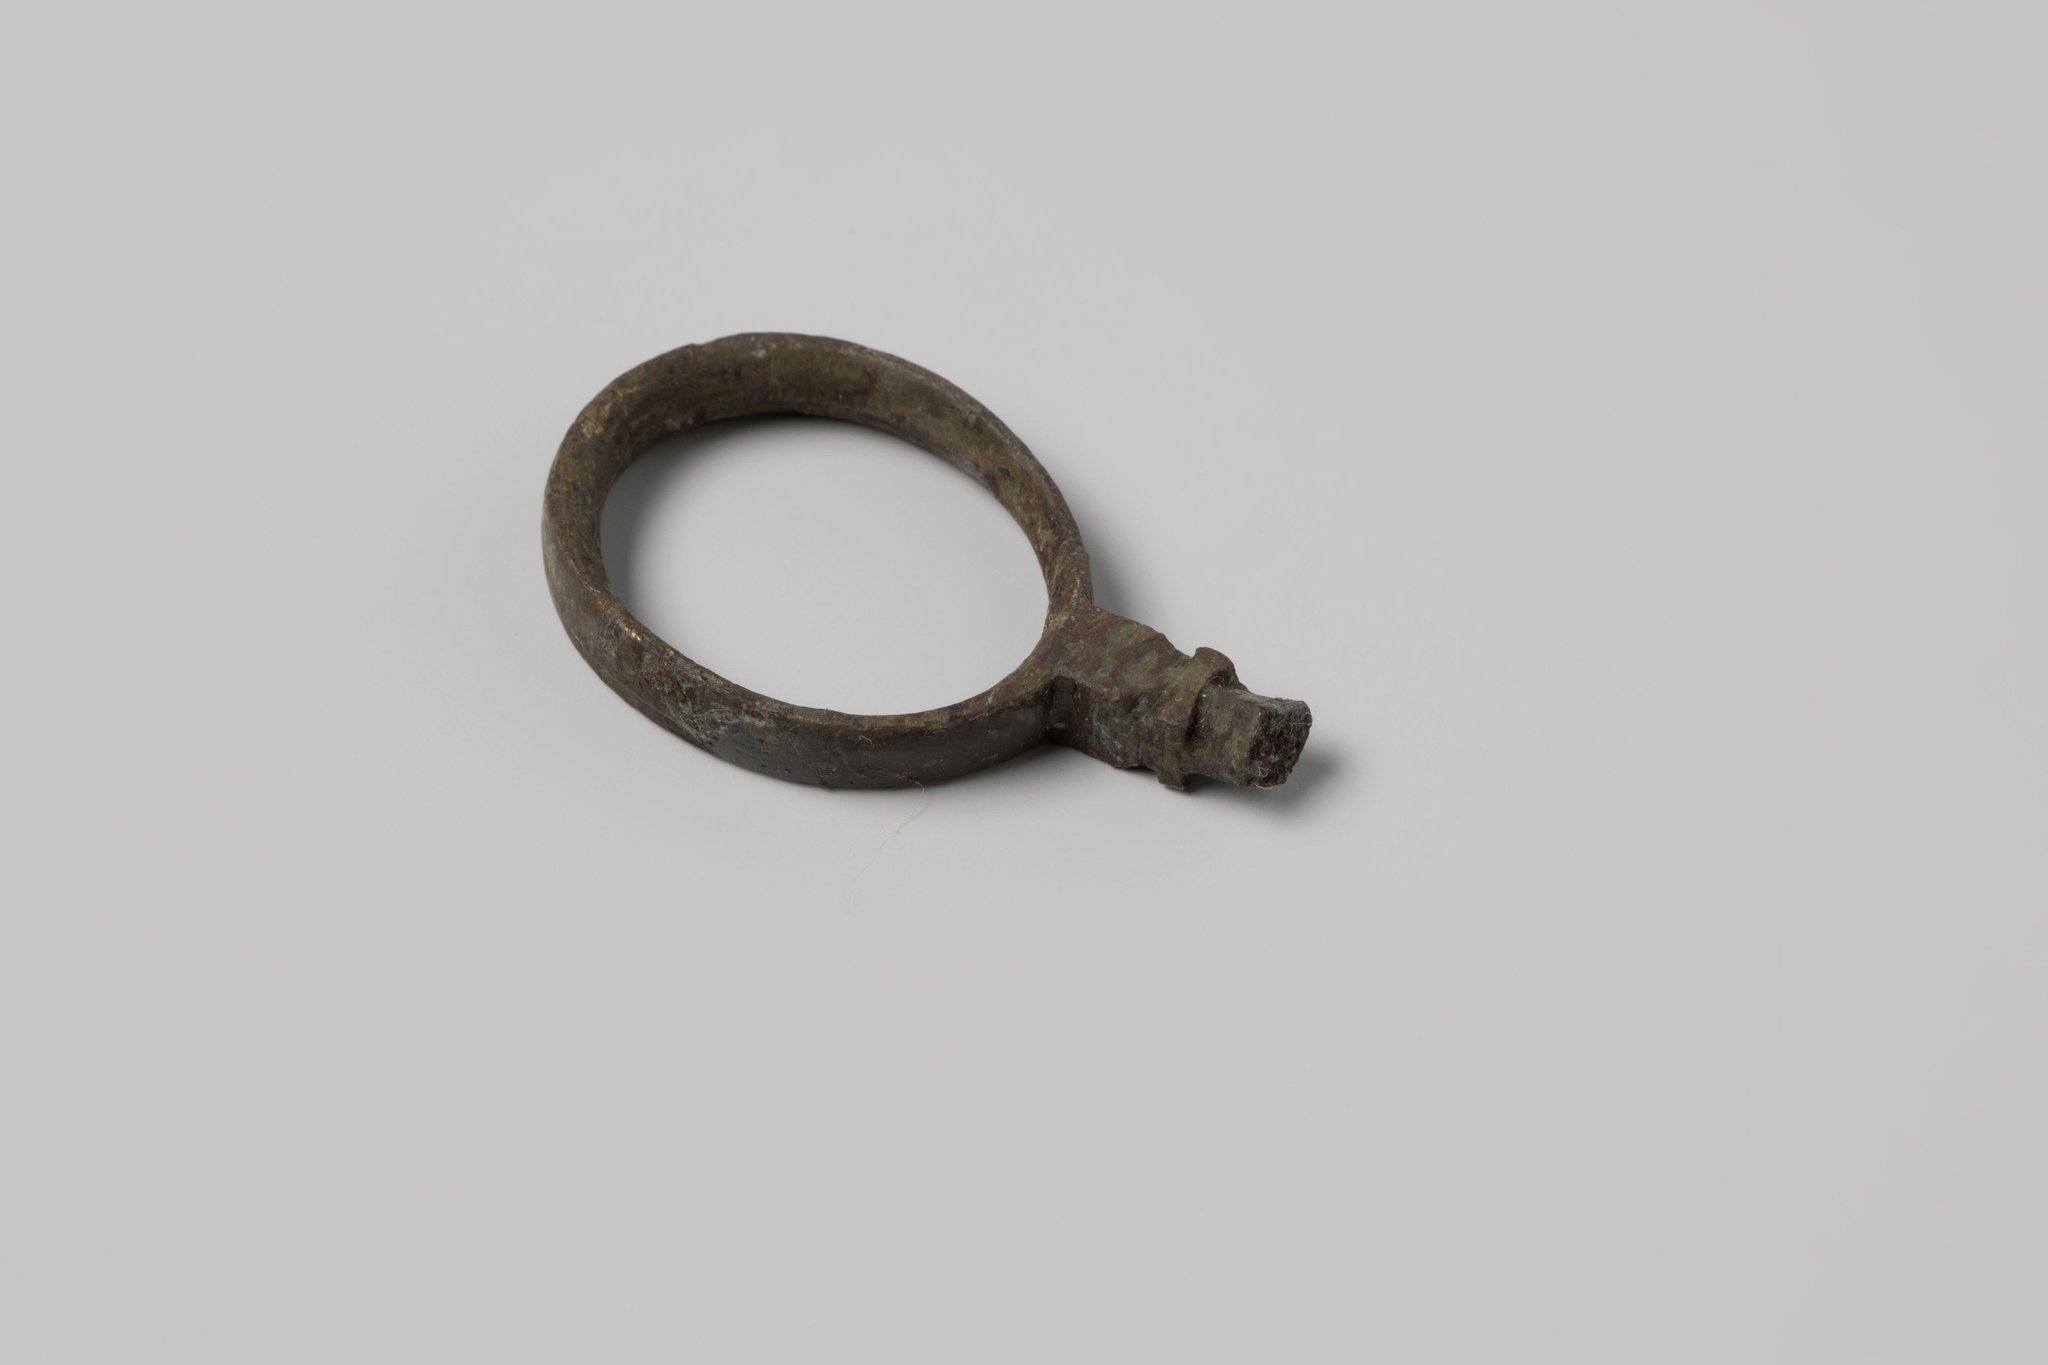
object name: pin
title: Speld uit het wrak van de Oost-Indiëvaarder Hollandia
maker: Anonymous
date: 1700-1743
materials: copper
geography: netherlands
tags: verenigde oostindische compagnie, hollandia (schip), annet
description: Tools and instruments, sewing and sailmaking, pin; fragm, bow, id. NG 1980-27H3265.